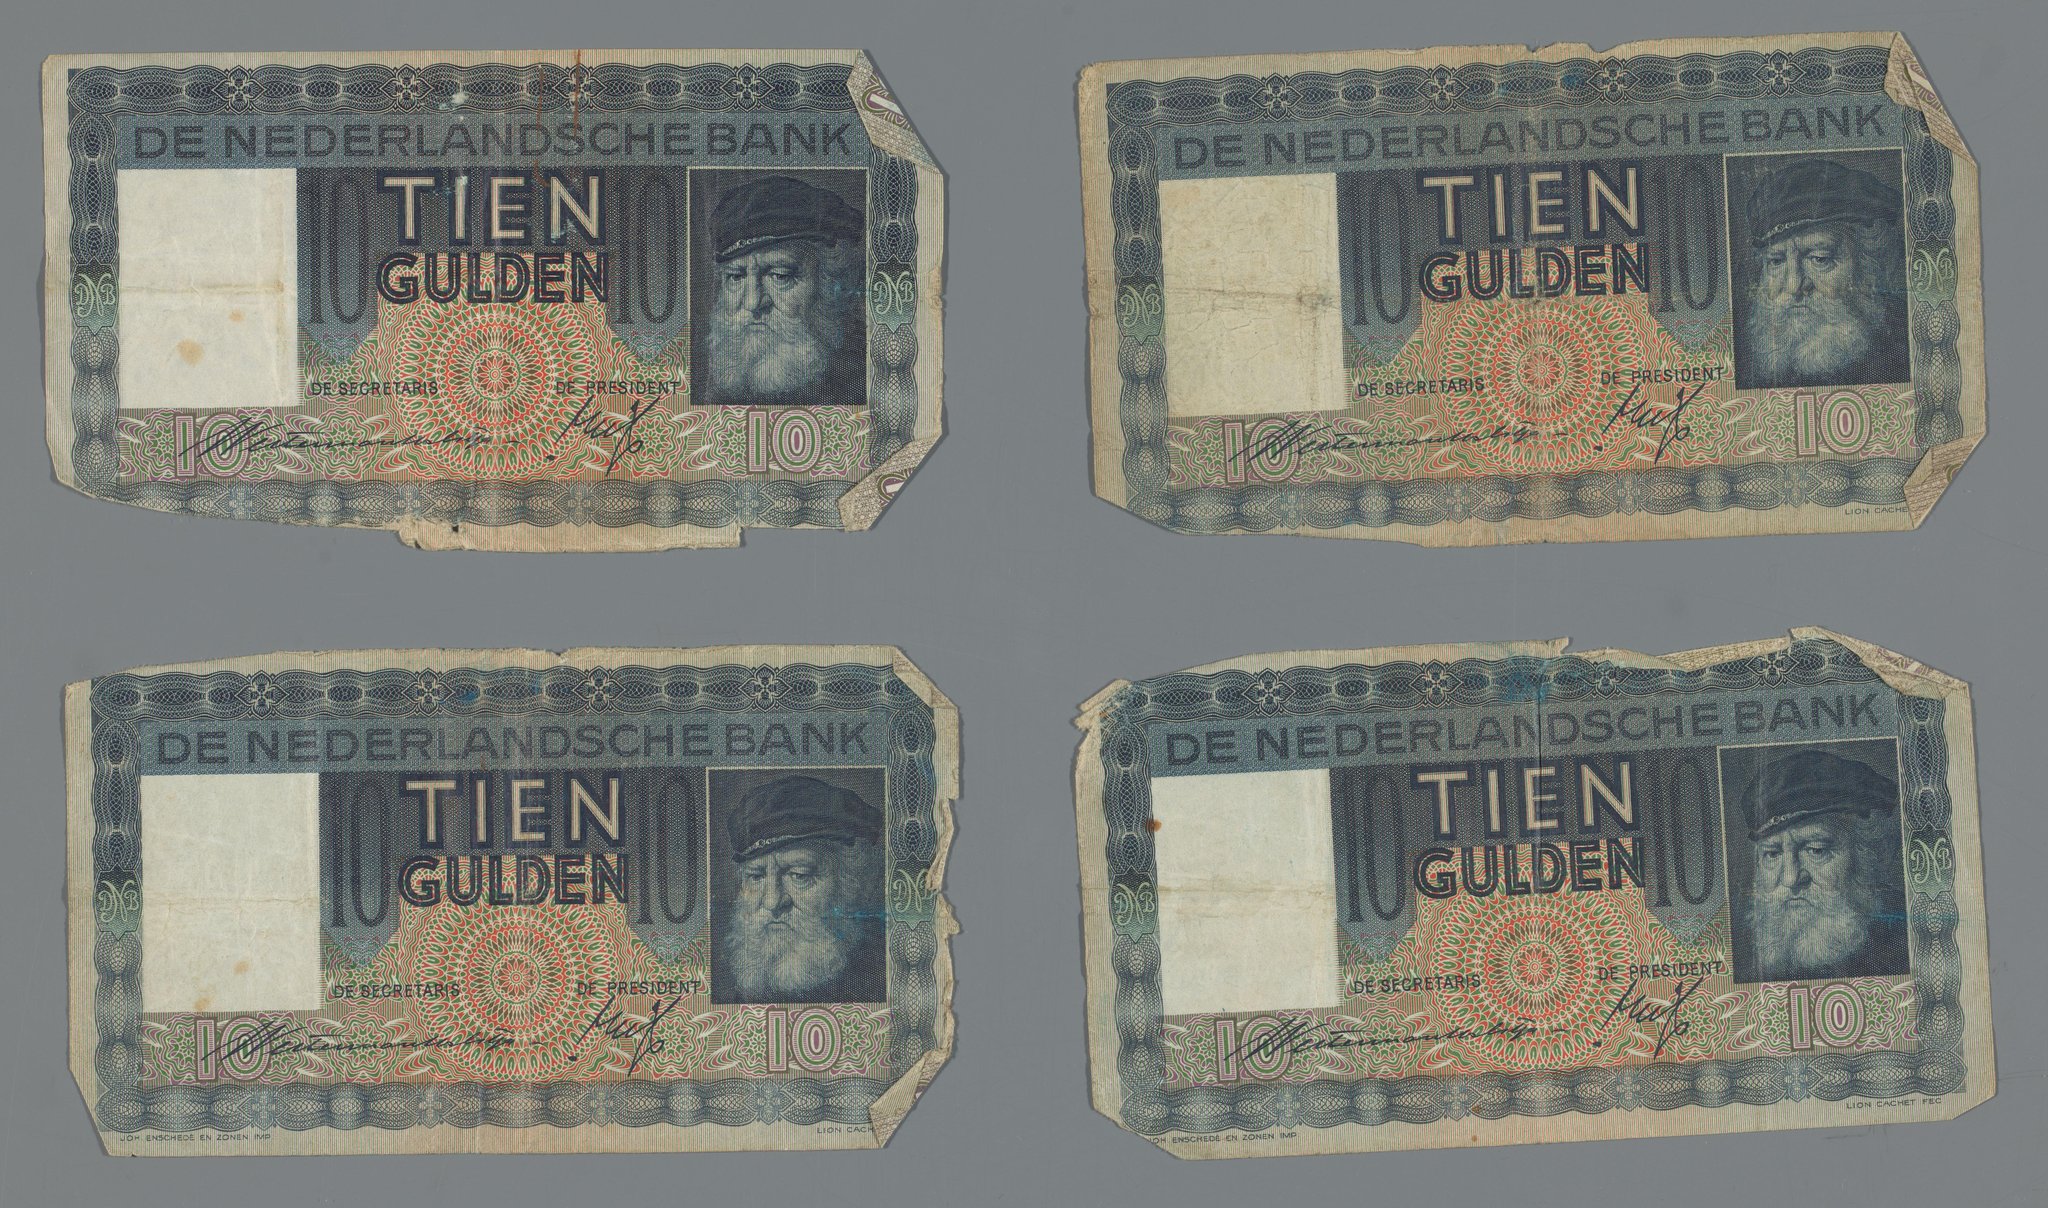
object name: bank note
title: tien gulden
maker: carel adolph lion cachet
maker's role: draughtsman, print maker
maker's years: 1864-1945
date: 1936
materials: paper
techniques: printing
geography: amsterdam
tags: netherlands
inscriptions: date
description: Vier bankbiljetten à f10,00, met op de voorzijde rechtsboven figuur de Grijsaard. Gesigneerd: voorzijde. Gedateerd: keerzijde.